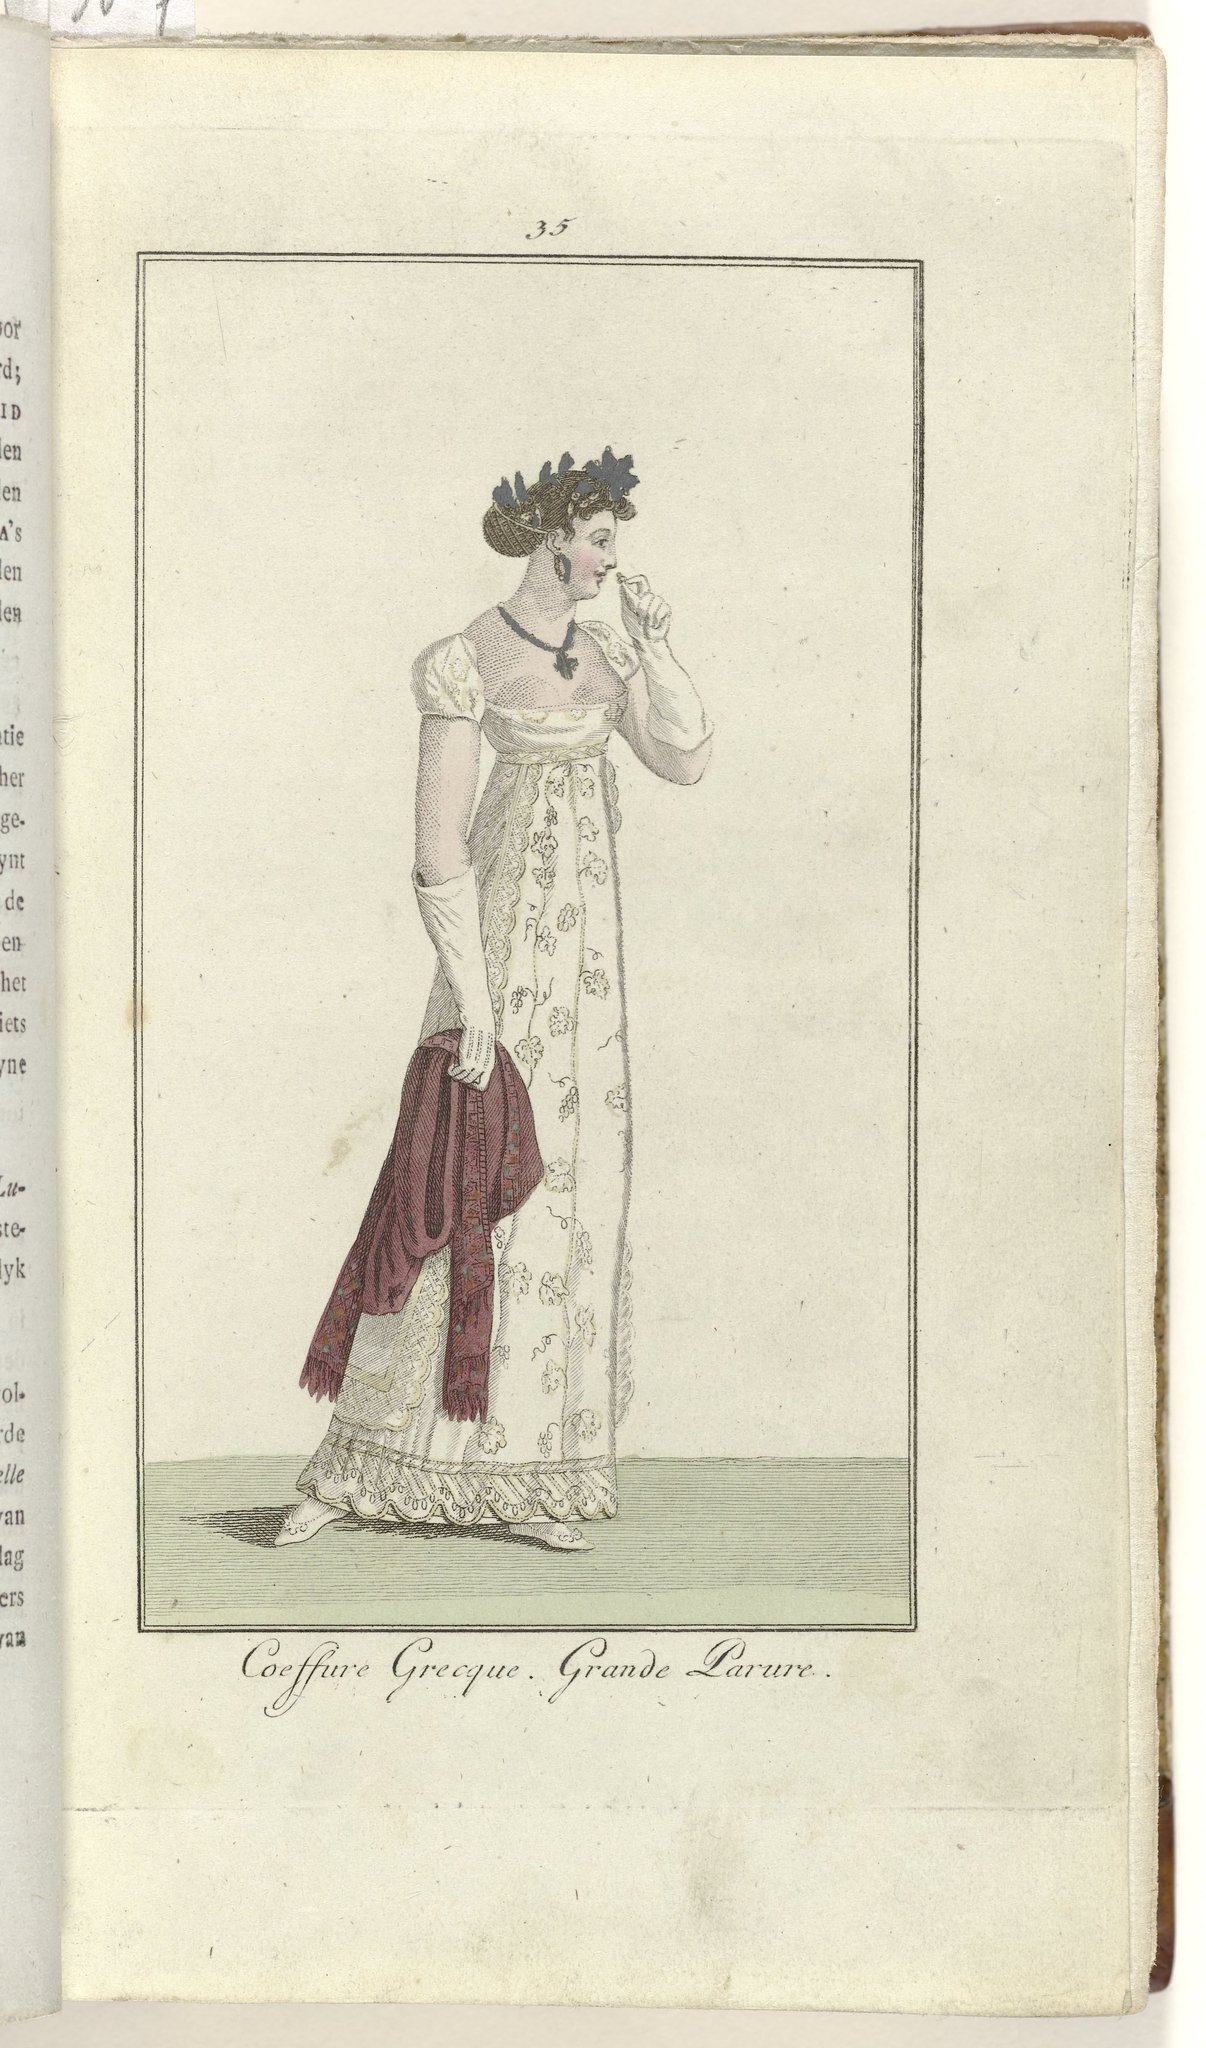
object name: magazine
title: Elegantia, of tijdschrift van mode, luxe en smaak voor dames, Februari 1808, No. 35: Coeffure Grecque...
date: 1808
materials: paper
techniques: engraving, hand coloring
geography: amsterdam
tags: ear-rings (+ women's clothes), gloves, mittens (long gloves) (+ women's clothes), clothing for the upper part of the body (shawl) (+ women's clothes), embroidery (ornamentation) (+ women's clothes), styles of hairdress - aa - ~ women, fashion plates, shoes, sandals (+ women's clothes), dress, gown (+ women's clothes), necklace (+ women's clothes)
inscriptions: caption: ‘Coeffure Grecque. Grande Parure.’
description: Volgens de begeleidende tekst (p. 64): 'Coëffure grecque'. Japon van mousseline geborduurd met diamanten. Wit satijnen 'biffon'(?) met geborduurde rand. Diamanten oorringen en collier. 'Shawl amaranthe' (sjaal). Wit satijnen schoenen. Prent uit het modetijdschrift Elegantia, of tijdschrift van mode, luxe en smaak voor dames 1807-1814 (onderbroken door de periode 1811-1813).